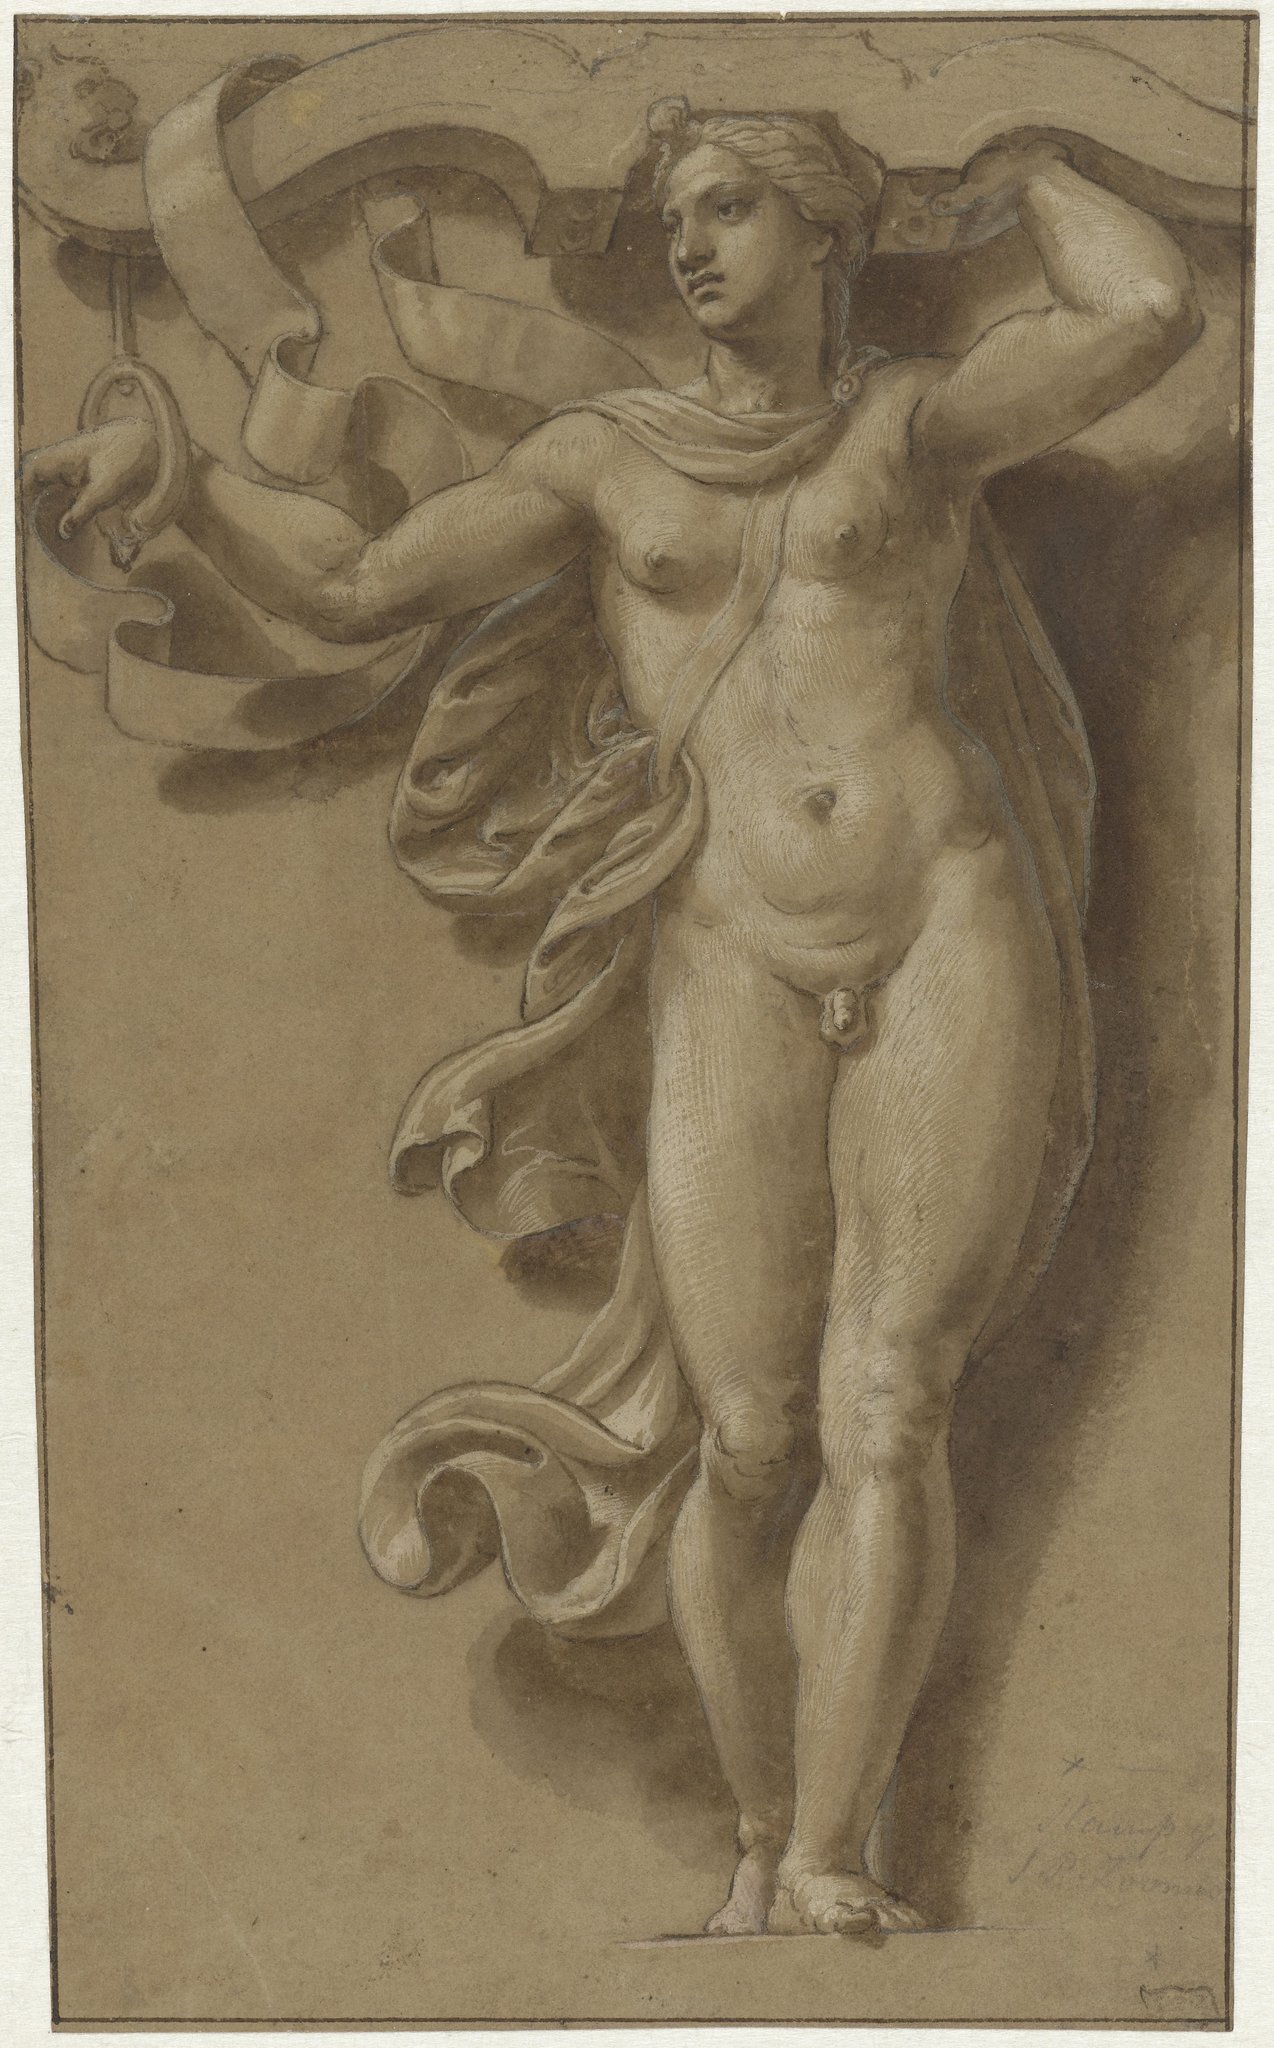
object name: drawing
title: Hermaphroditus as Caryatid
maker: giulio romano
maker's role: draughtsman, painter, print maker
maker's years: 1499-1546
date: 1510-1521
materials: ink, paper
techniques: brush, pen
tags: (story of) hermaphroditus